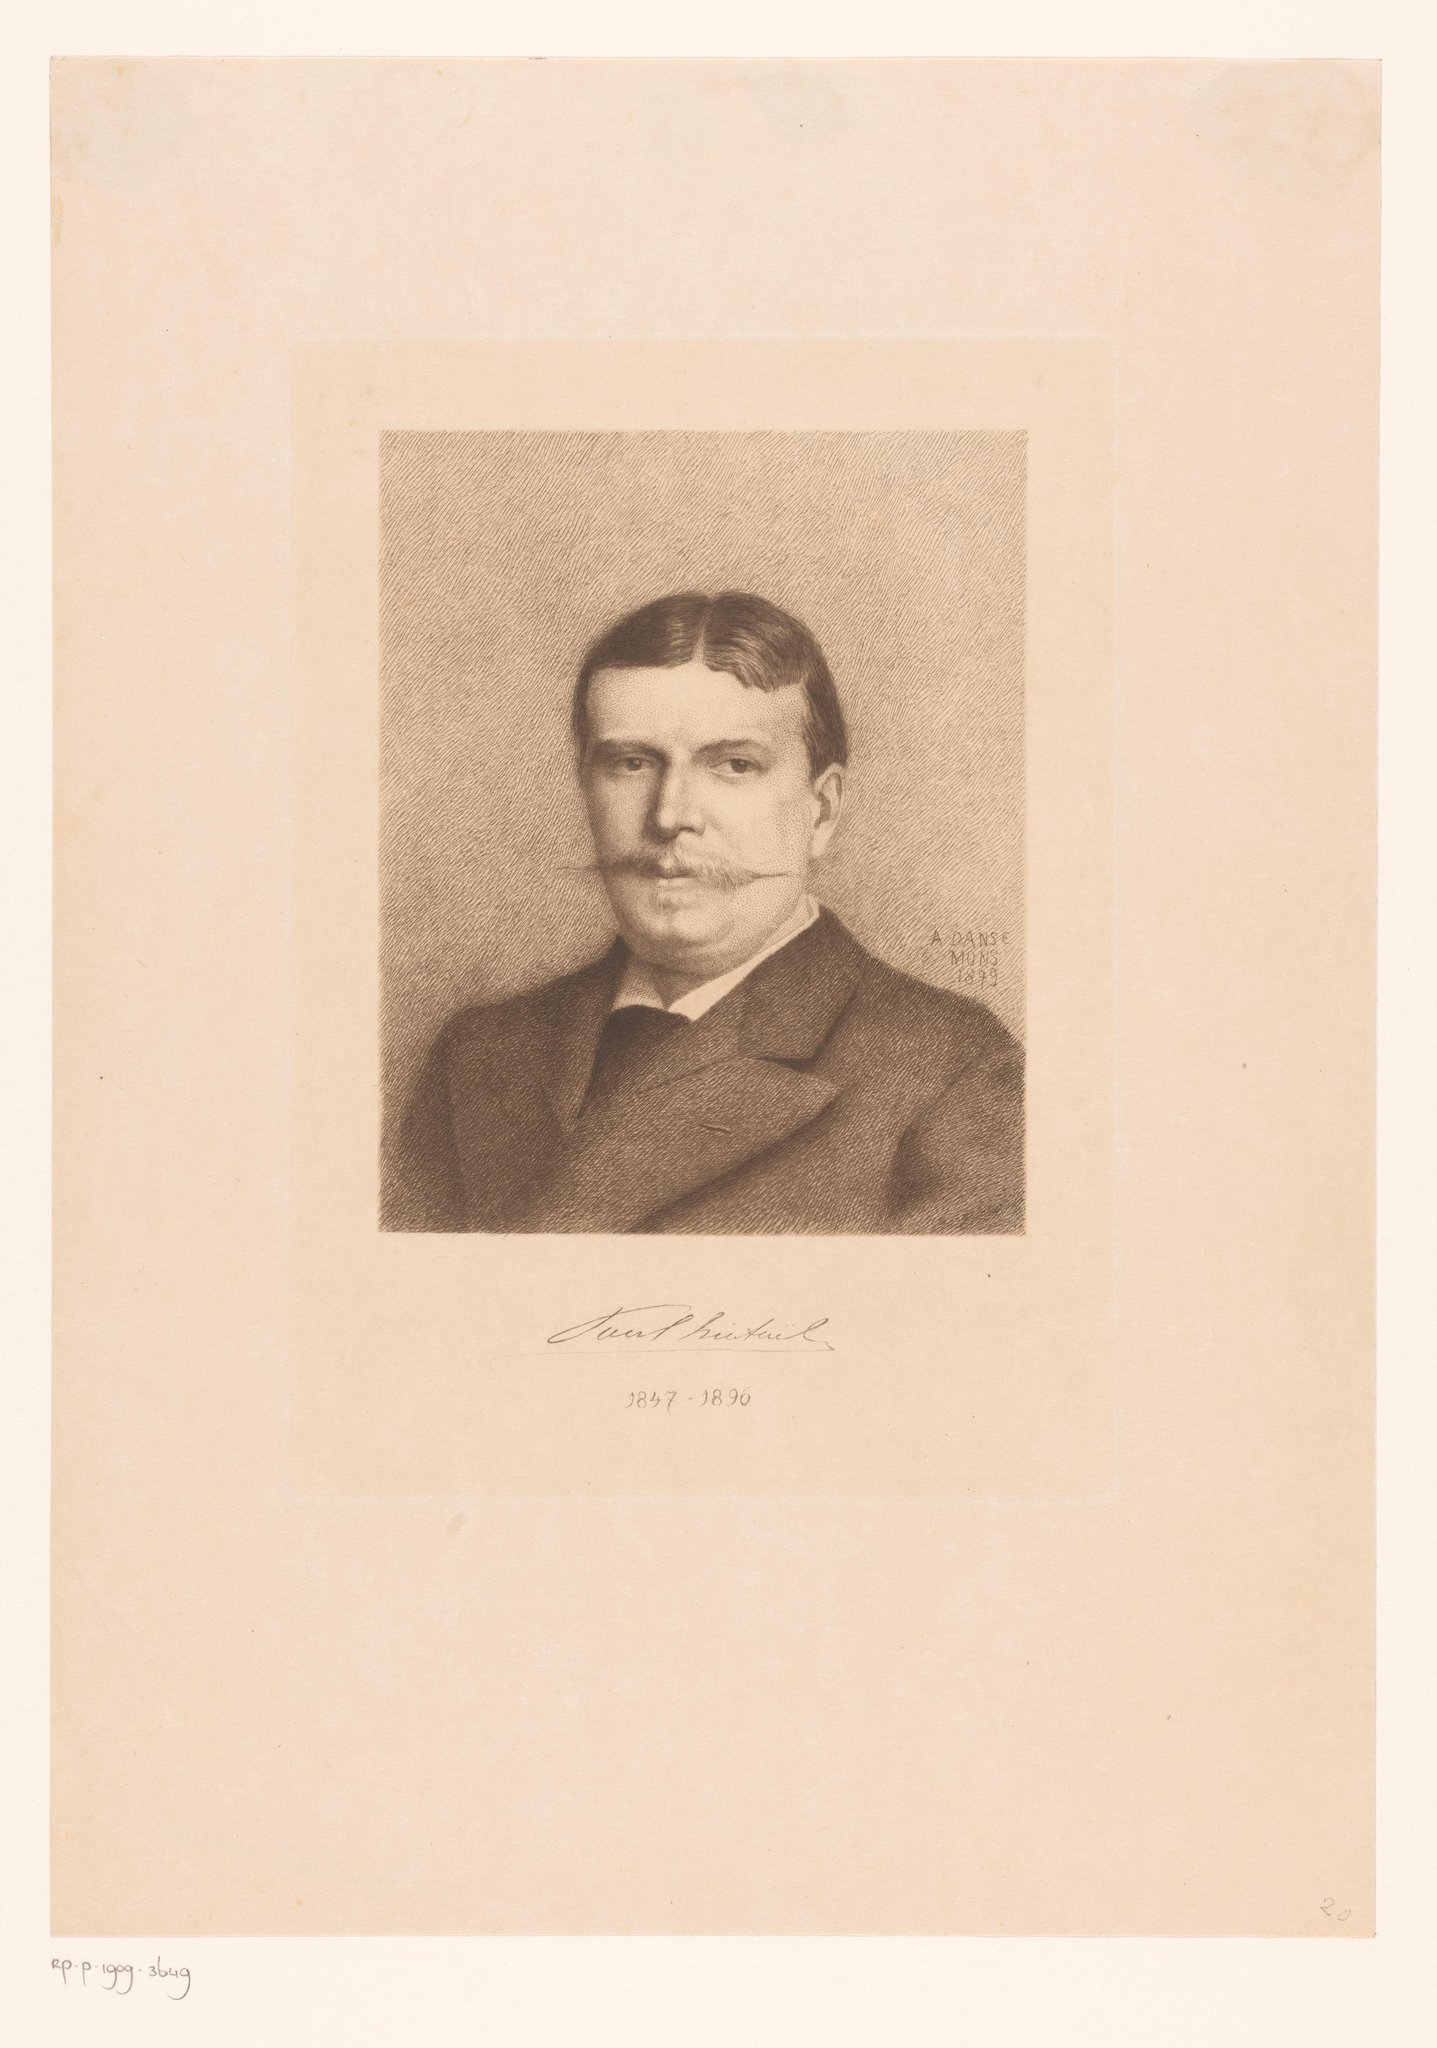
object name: print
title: Paul Spitaëls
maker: auguste danse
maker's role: print maker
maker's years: 1829-1929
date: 1897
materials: paper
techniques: drypoint, etching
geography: bergen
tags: anonymous historical person portrayed alone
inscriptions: collector's mark: Lugt 2228